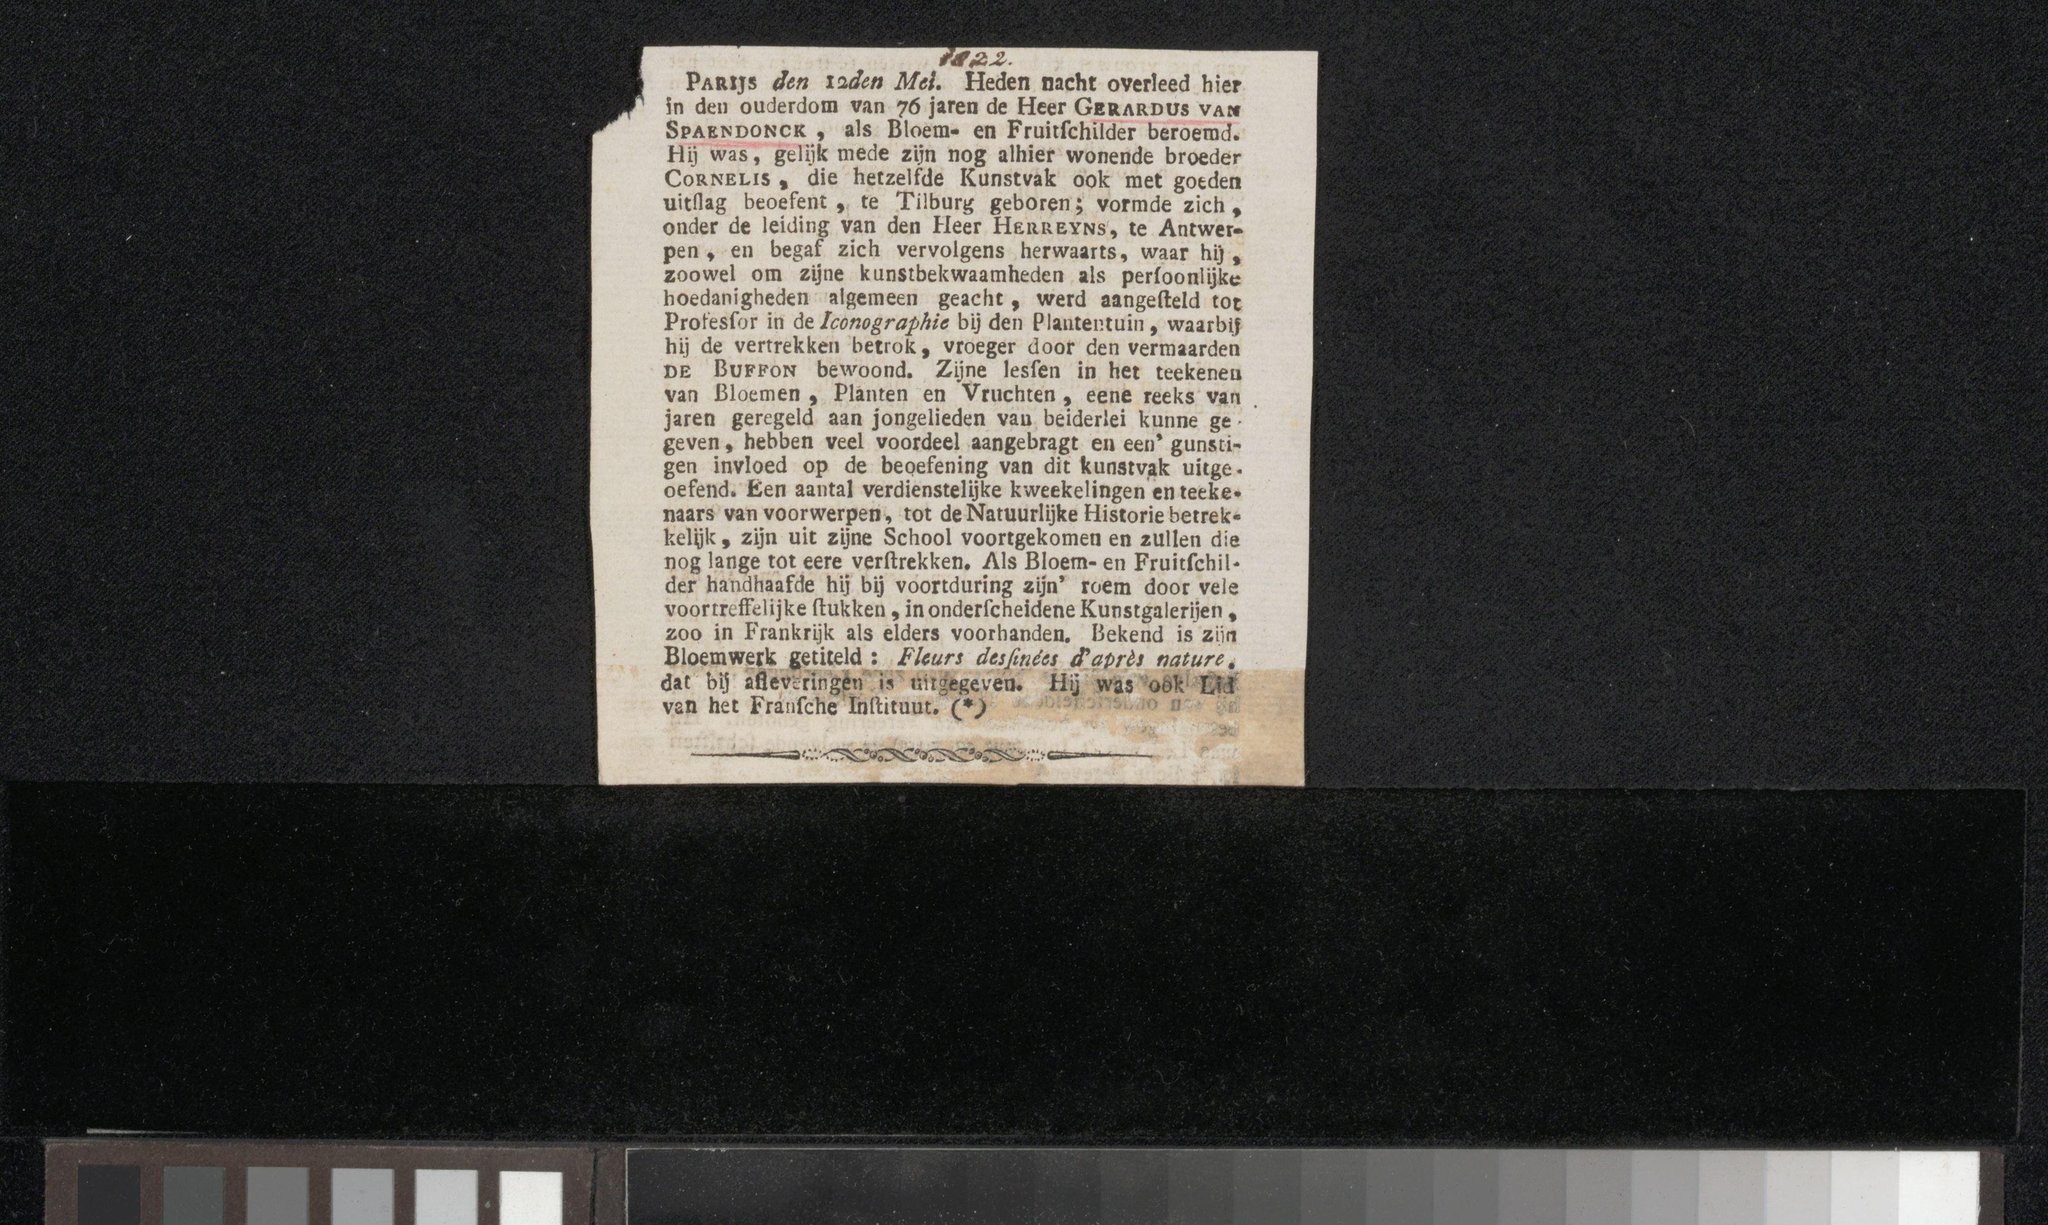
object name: newspaper clipping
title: Krantenknipsel betreffende Gerard van Spaendonck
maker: Anonymous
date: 1822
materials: paper, ink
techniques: printing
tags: paris, print maker, draughtsman, gerard van spaendonck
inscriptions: collector's mark: Lugt 2233